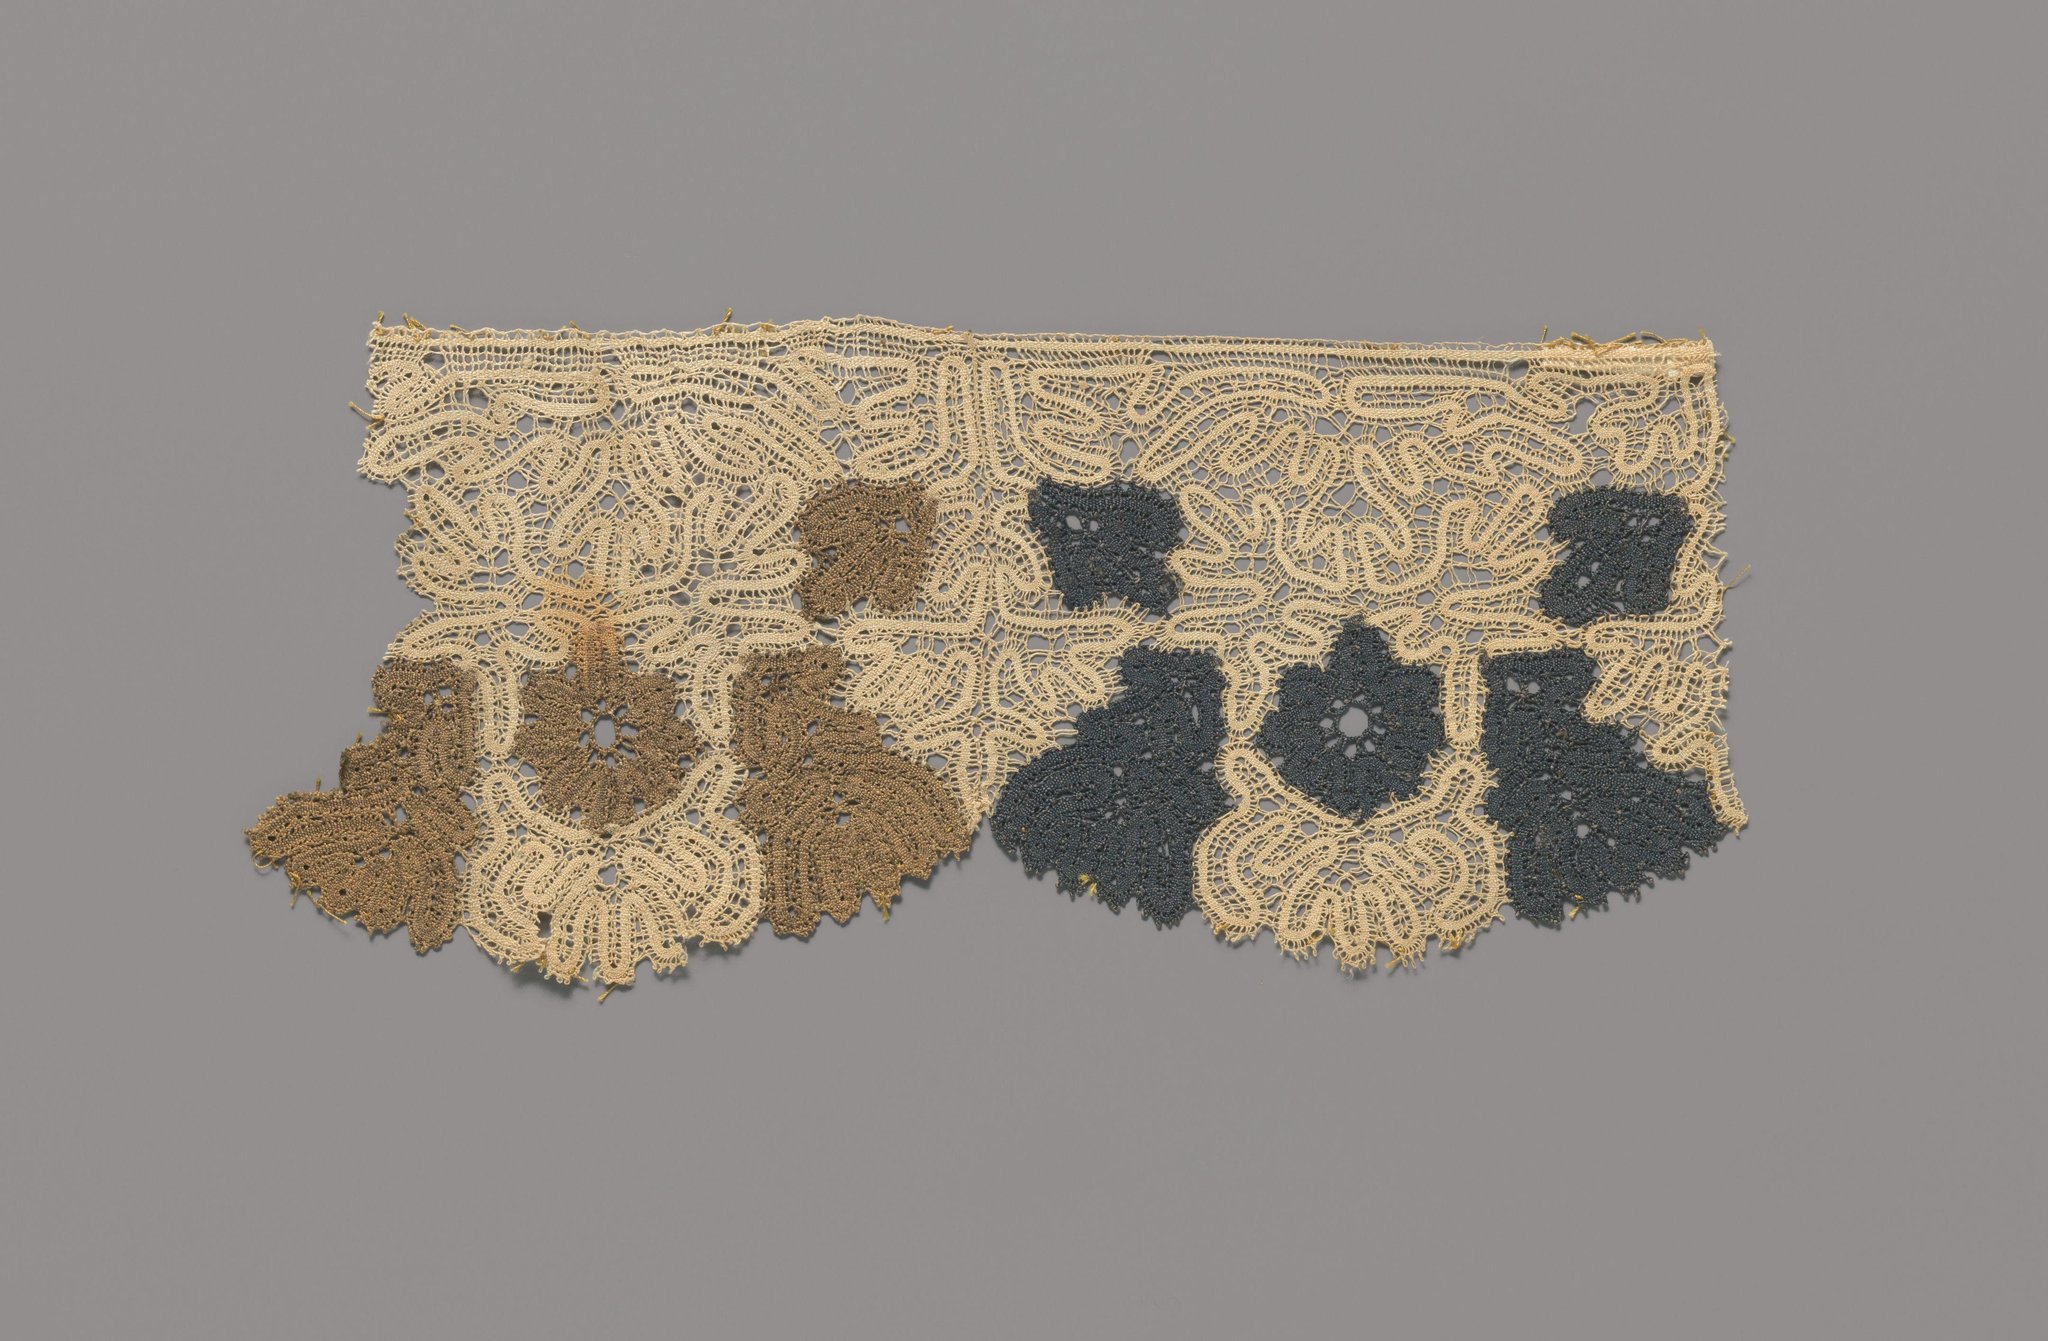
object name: strip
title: Strook gekleurd kloskant met kronkelend lint dat een symmetrisch patroon vormt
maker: Anonymous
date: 1850-1899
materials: linen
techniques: lace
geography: l'aquila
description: Strook gekleurd kloskant: Abruzzen-kant. Een sterk kronkelend lint in linnenslag vormt symmetrische motieven, die samen een symmetrisch patroon vormen. Het symmetrische patroon herhaalt zich. De herhaling in een patroon noemt men een rapport. In één rapport zijn enkele motieven bruin gekleurd: de centraal geplaatste rozetbloem en twee paar schuin afhangende bladeren. In het volgende rapport zijn deze motieven donkerblauw gekleurd. De overige motieven zijn naturelkleurig. Het kant is vermoedelijk in één keer geklost aangezien de motieven ten dele met een naturelkleurige en ten dele met een gekleurde draad zijn ingehaakt. De bovenzijde van de strook is recht afgewerkt. De schulpenrand langs de onderzijde komt voort uit het patroon en is afgewerkt met picots. Het sterk kronkelende lint zorgt voor lobjes langs de brede gebogen schulpen.